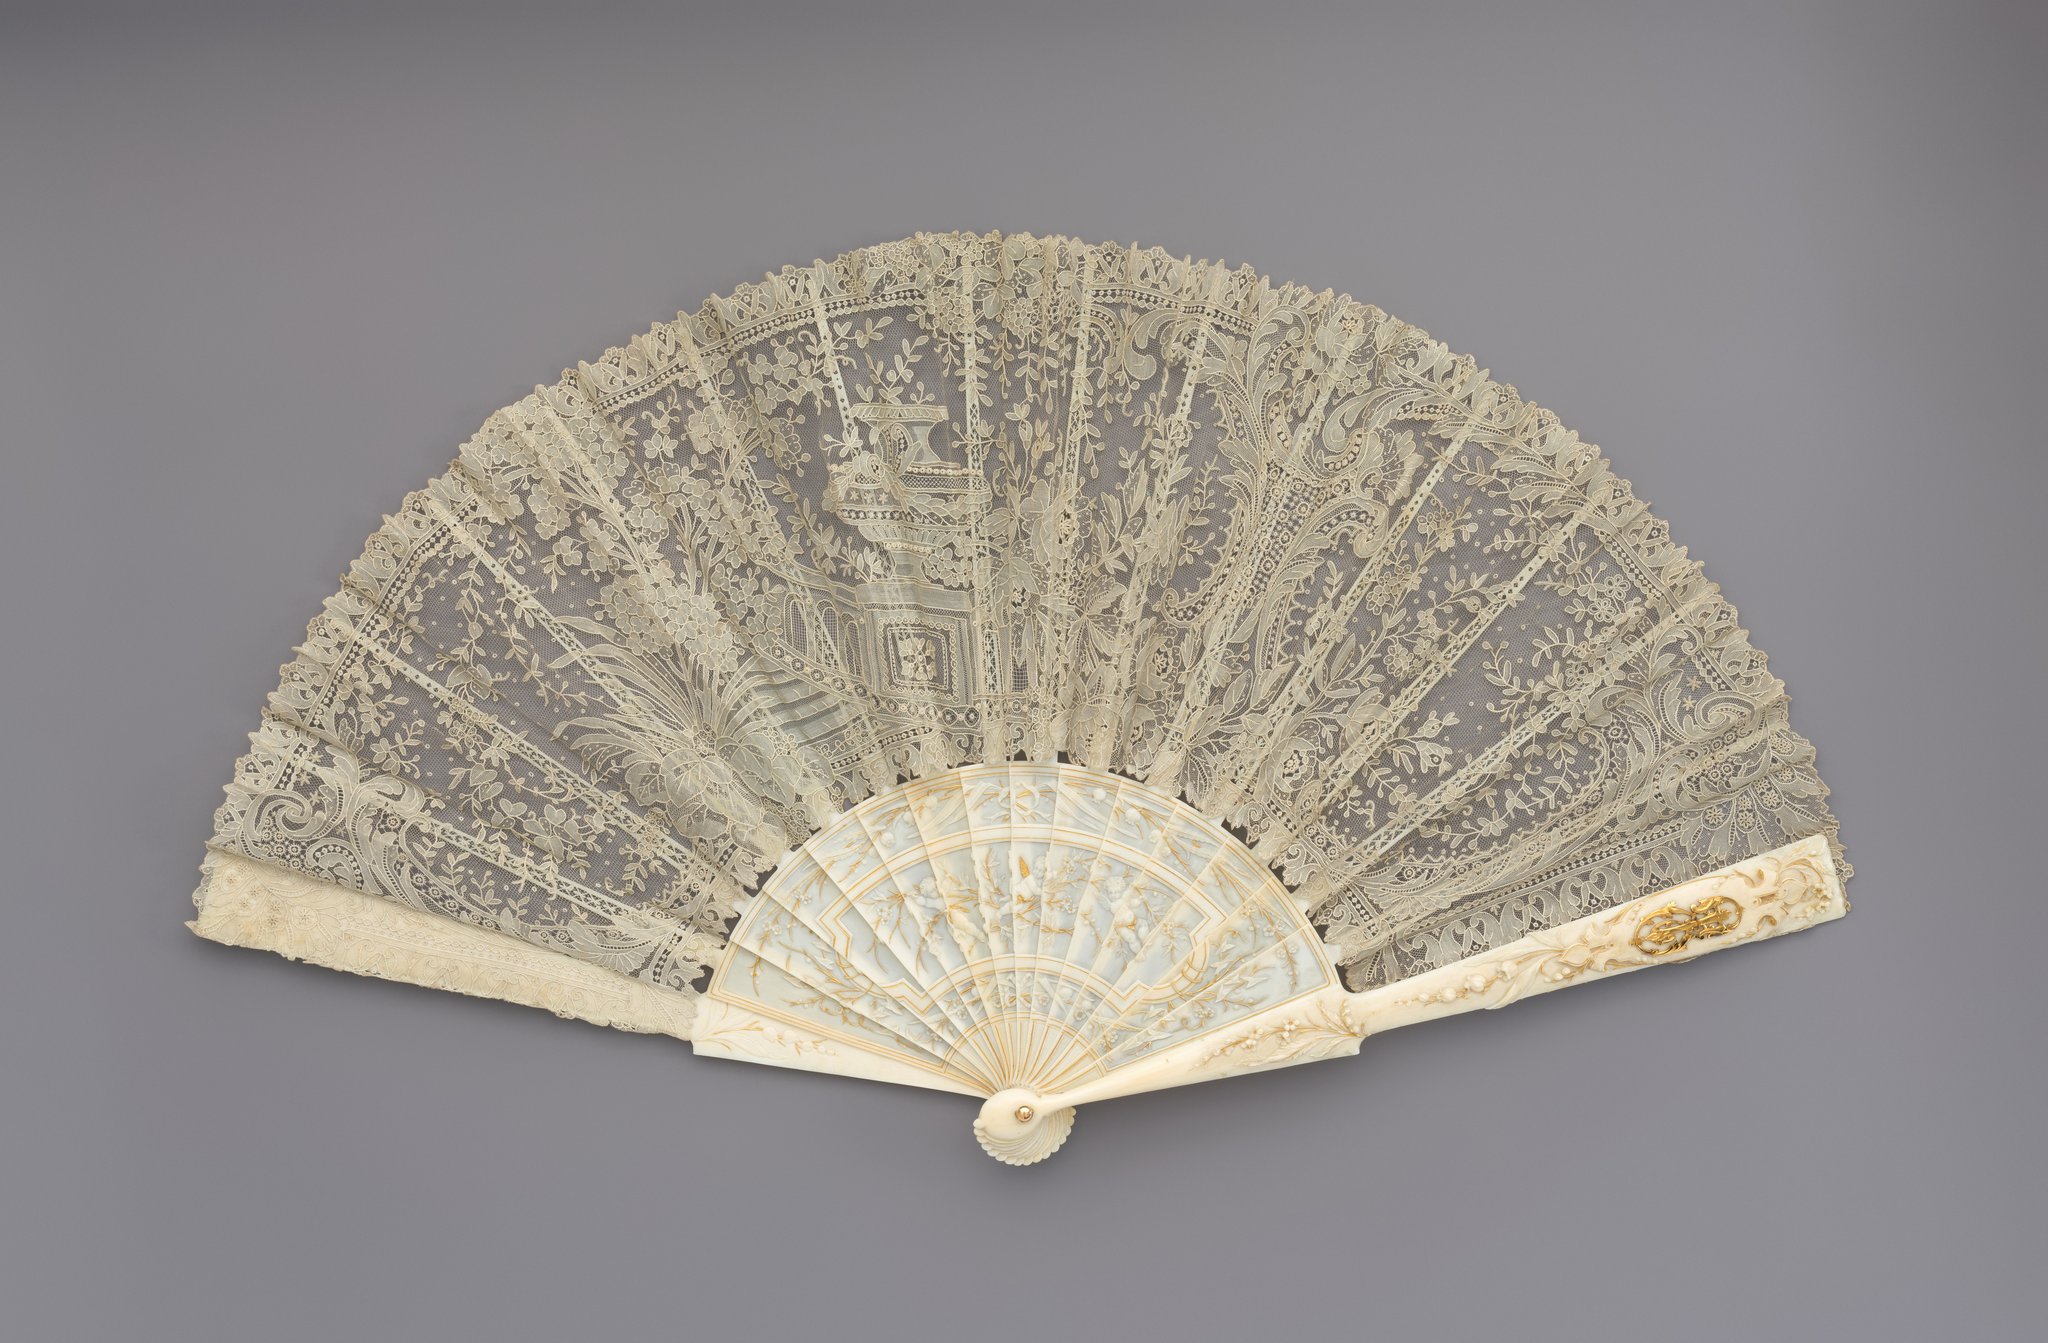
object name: fan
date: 1876-1900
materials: ivory, lace